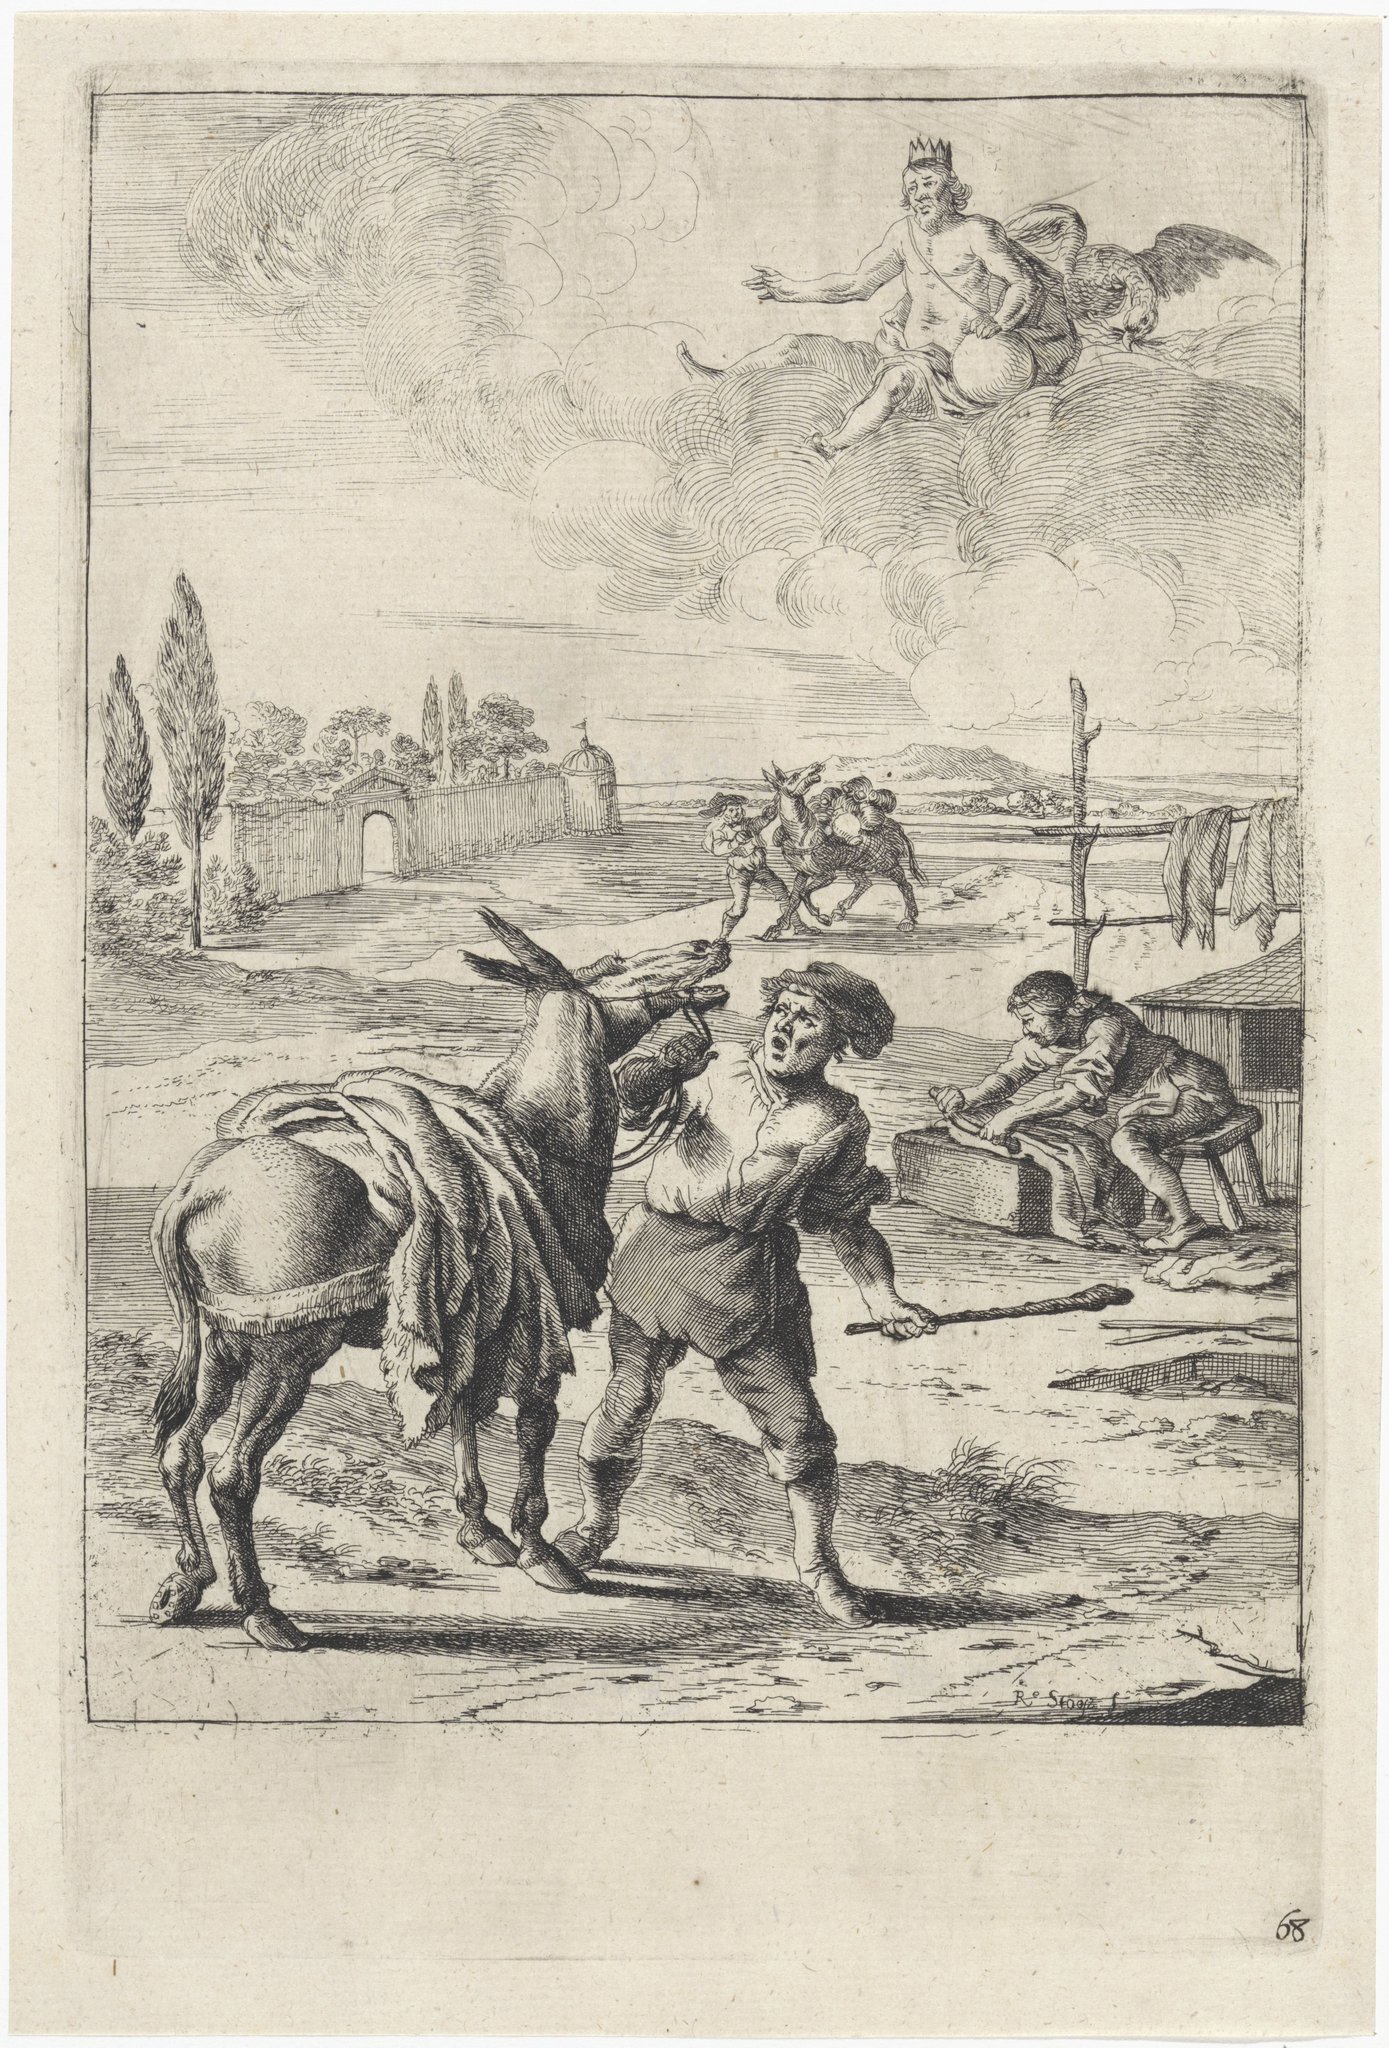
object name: book illustration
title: Fabels van Aesopus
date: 1665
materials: paper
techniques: etching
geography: london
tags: ass, donkey, (story of) jupiter (zeus), fables, attributes of jupiter: eagle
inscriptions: collector's mark: Lugt 2228, collector's mark: Lugt 2610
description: Een ezel, op wiens rug huiden zijn gelegd, went zich tot Jupiter op de wolken. Rechts een leerlooier aan het werk. Op de achtergrond een bepakte ezel. Illustratie van een fabel van Aesopus.